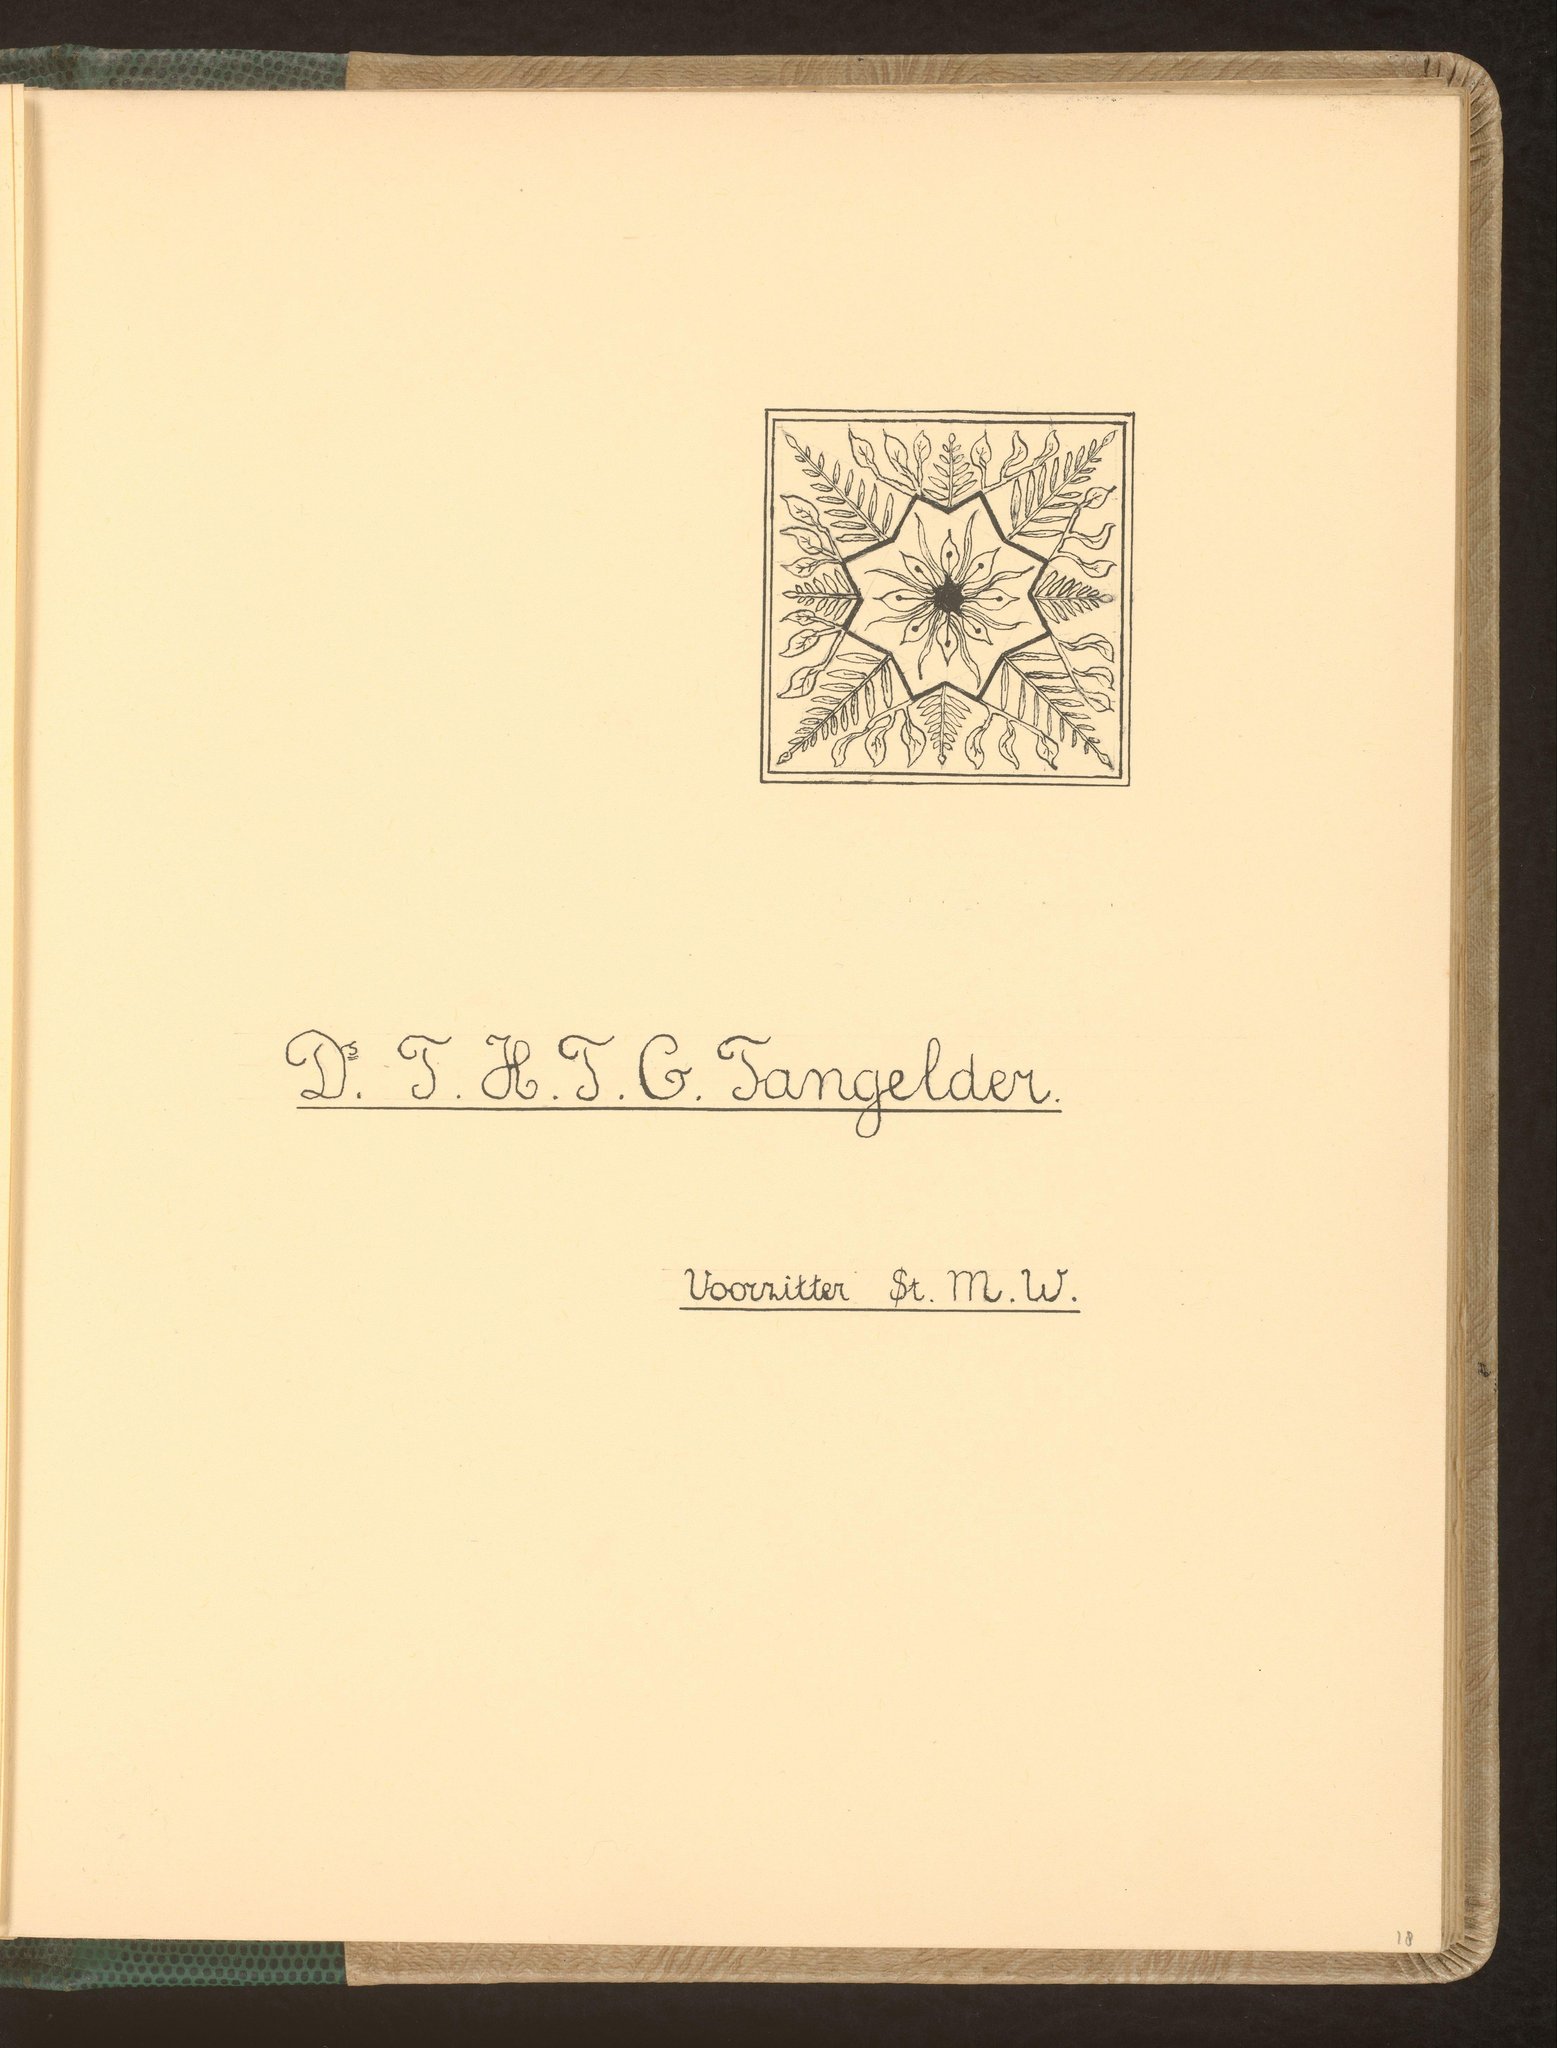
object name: album leaf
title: Ds. T.H.T.G. Tangelder. / Voorzitter St. M.W.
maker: Anonymous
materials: ink, paper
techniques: handwriting, pen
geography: lochem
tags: amsterdam, the hague, willem drees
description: Handgeschreven titel voor de foto op het volgende blad. Onderdeel van het fotoalbum over de opening van het bejaardenhuis De Berkelhof in Lochem door premier Willem Drees op 8 augustus 1953.